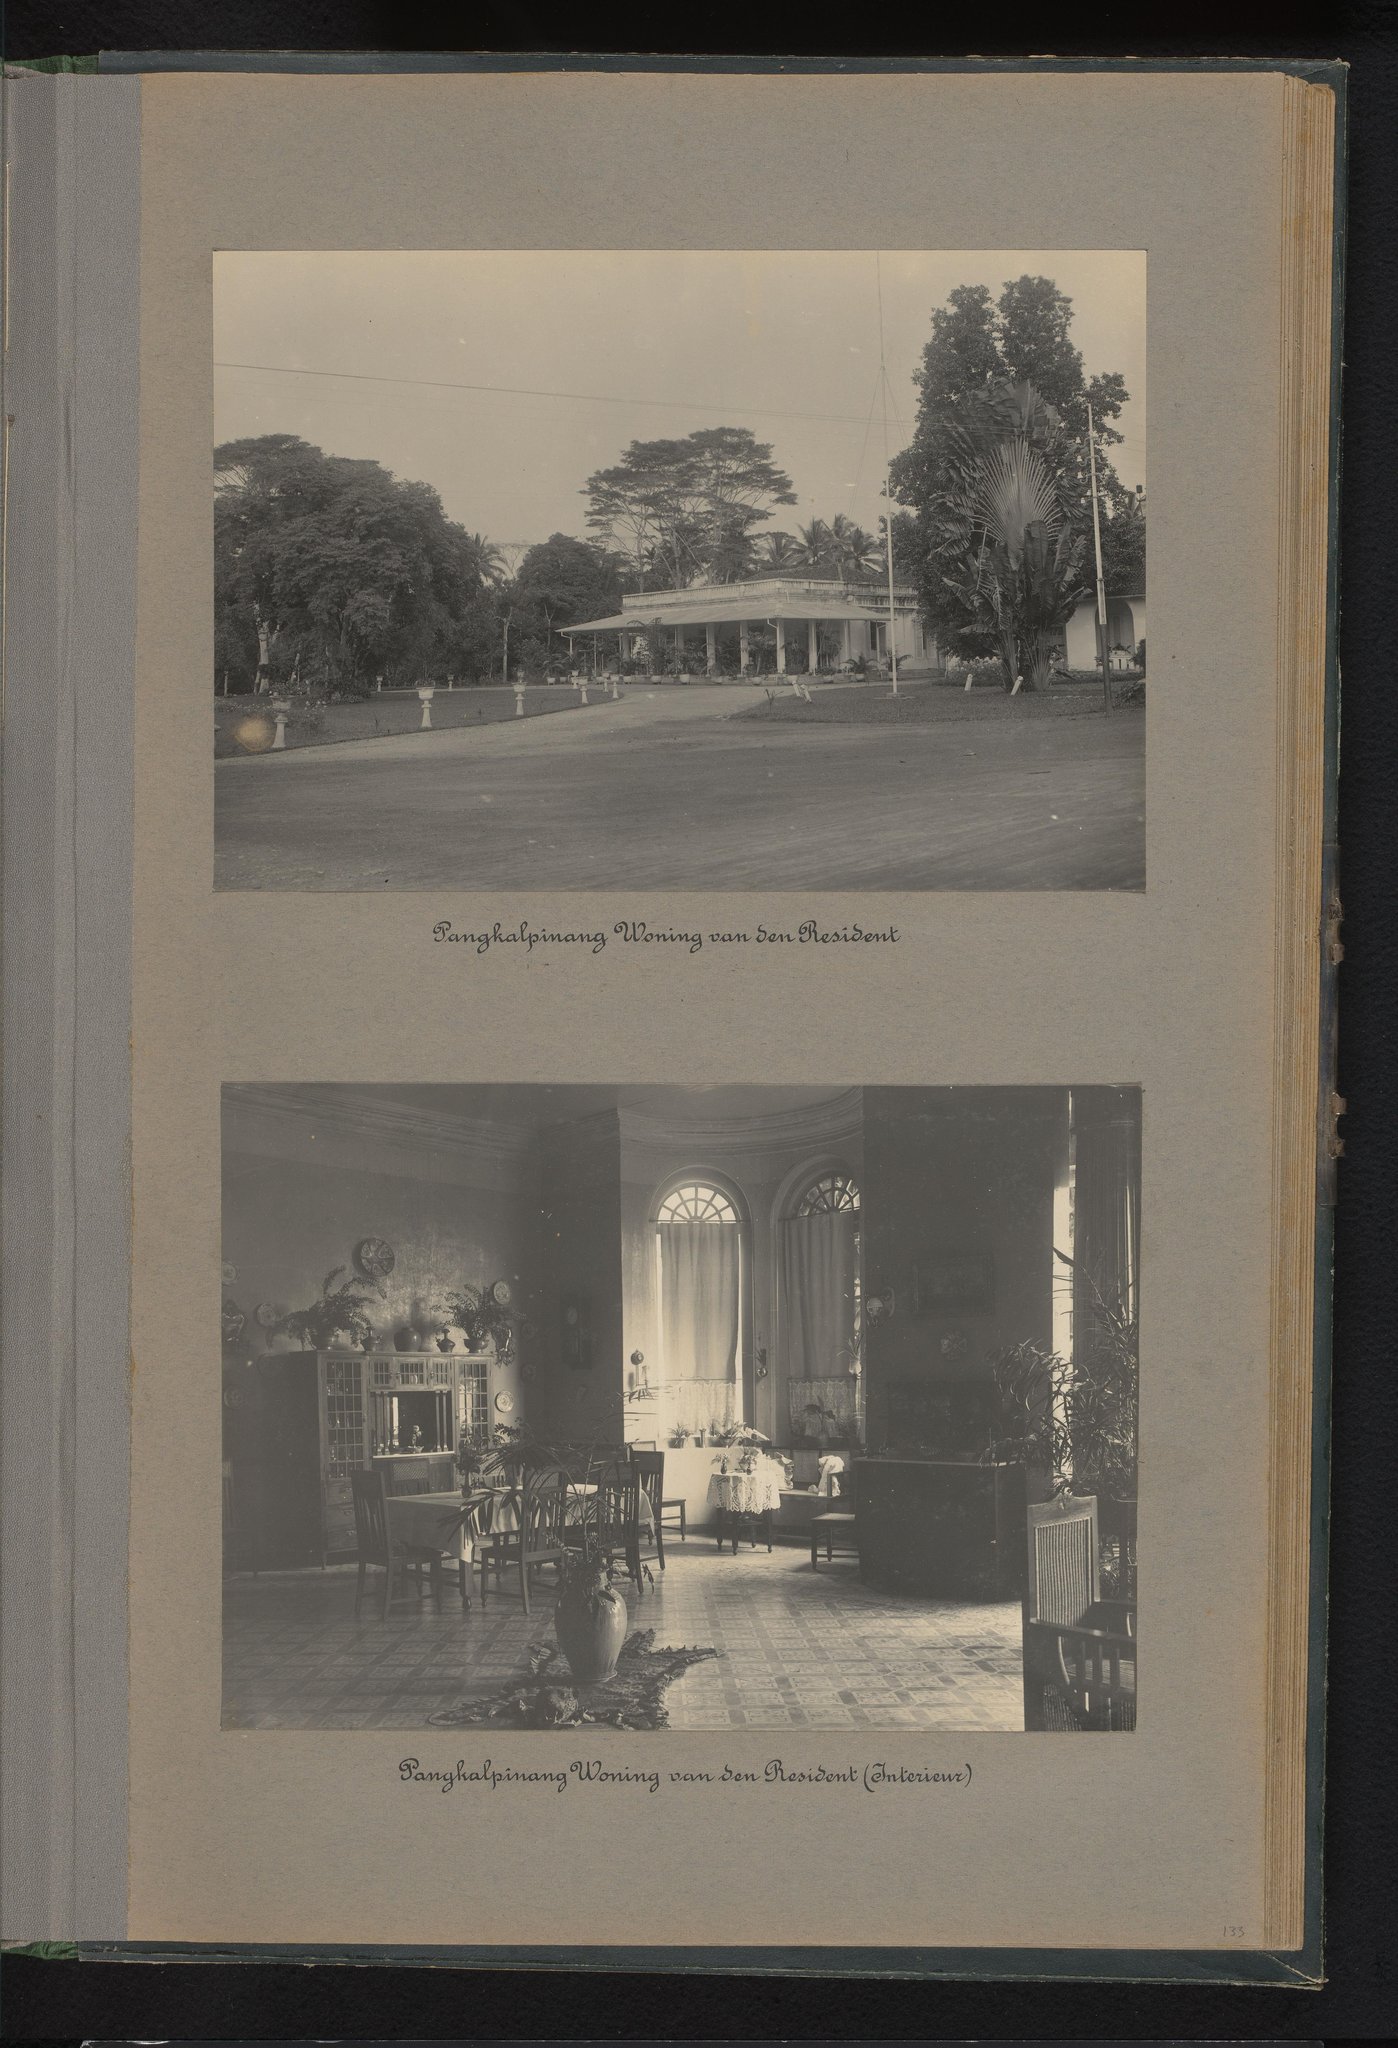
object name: album leaf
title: Woning van de resident te Pangkalpinang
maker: Anonymous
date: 1914-1919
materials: cardboard, photographic support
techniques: gelatin silver print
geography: bangka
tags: robert julius boers, colonial system, colonial governor, mining, interior of the house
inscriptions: inscription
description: Albumblad met 2 foto's van het exterieur en interieur van de woning van de resident te Pangkalpinang. Onderdeel van het fotoalbum aangeboden aan Robert Julius Boers bij zijn vertrek naar Nederland in 1919 door het personeel van de Banka-tinwinning.